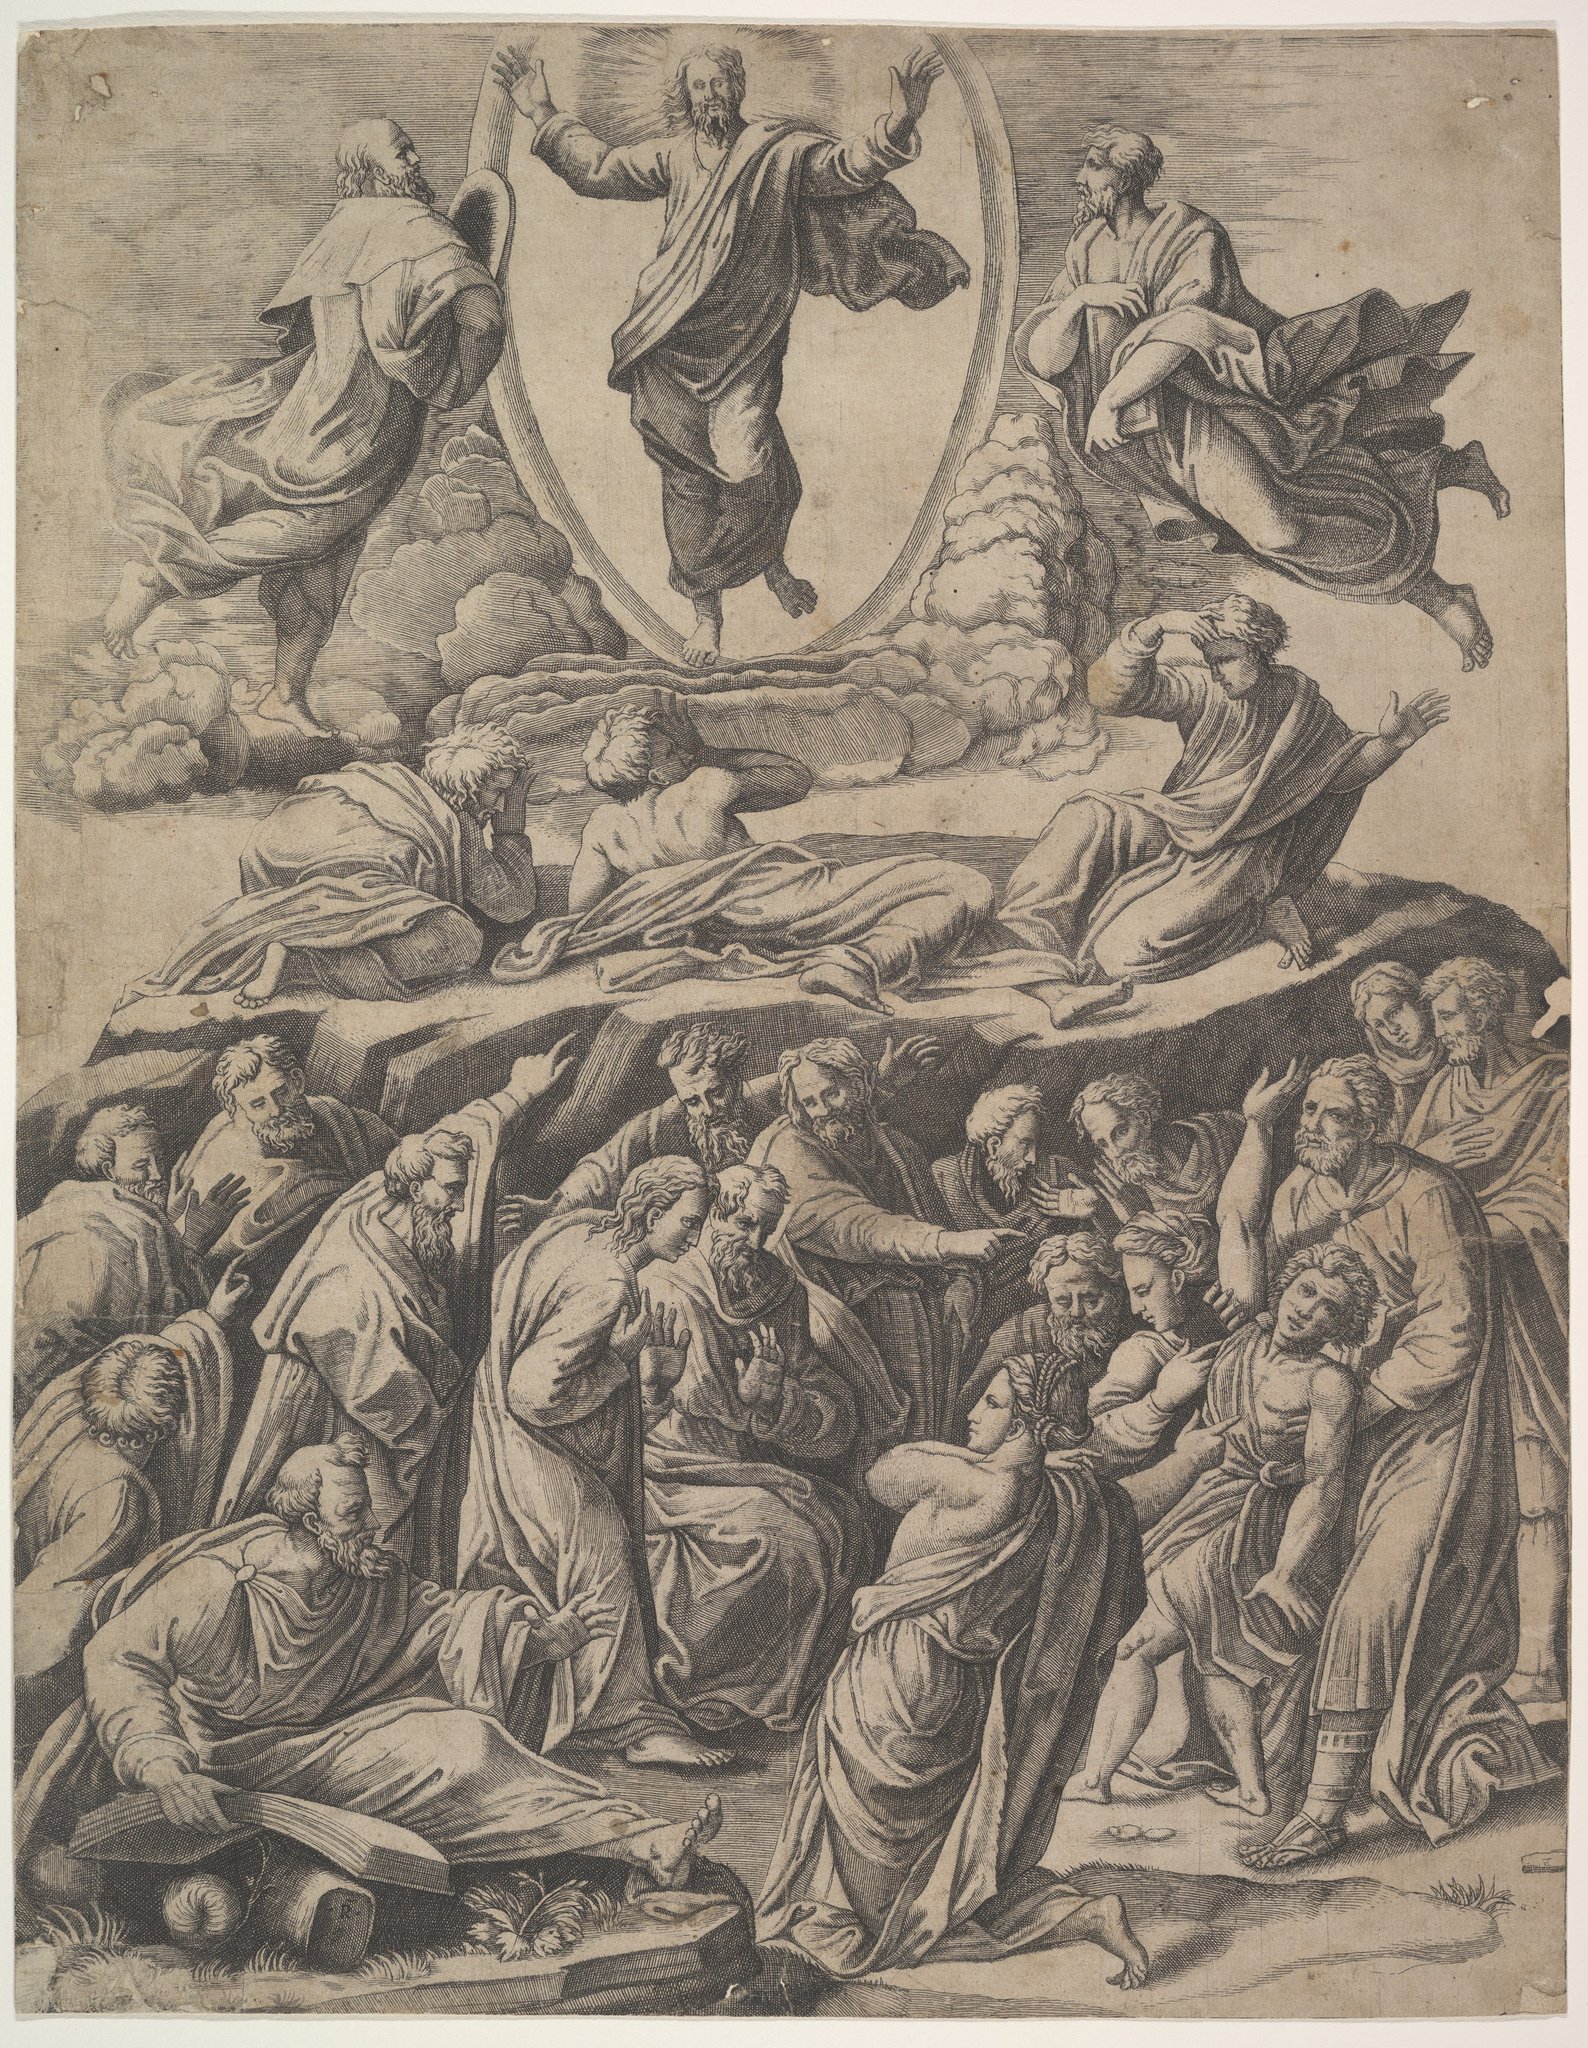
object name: print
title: The Transfiguration of Christ who appears upper centre, below him various figures including the Apostles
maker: master of the die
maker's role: artist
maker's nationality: italian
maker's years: 1525-1560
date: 1530-1560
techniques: engraving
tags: apostles,christ